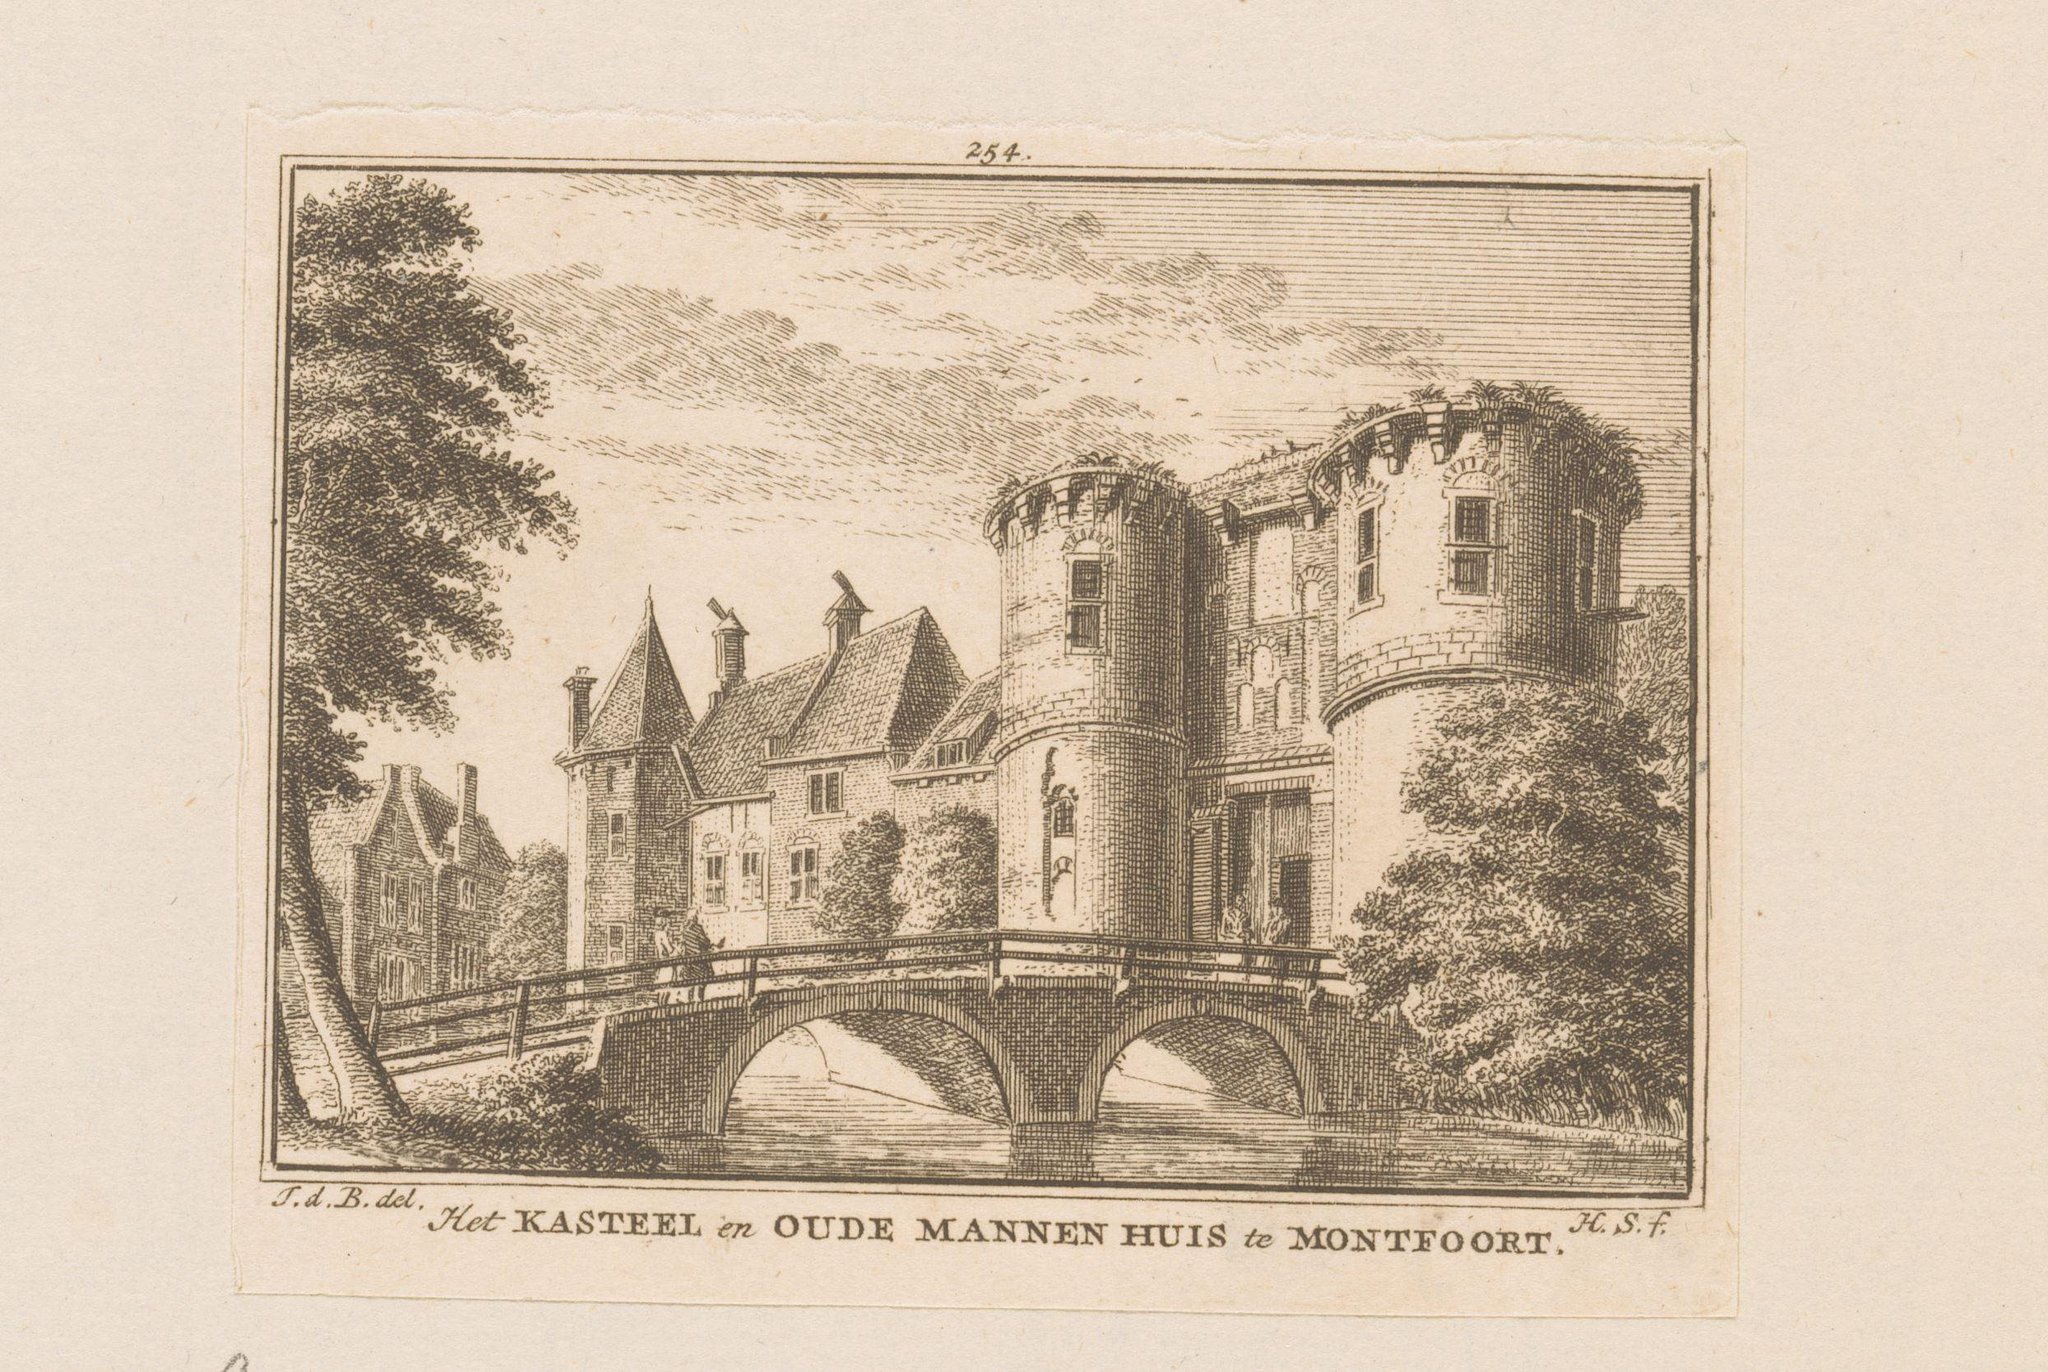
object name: print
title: Gezicht op de voorpoort van kasteel Montfoort en het Oudemannenhuis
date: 1745-1774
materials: paper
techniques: etching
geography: amsterdam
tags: castle, river, bridge in village across river, canal, etc.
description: Prent gebruikt in: Het verheerlykt Nederland of kabinet van hedendaagsche gezigten (...). Amsterdam: Isaac Tirion,1745-1774.